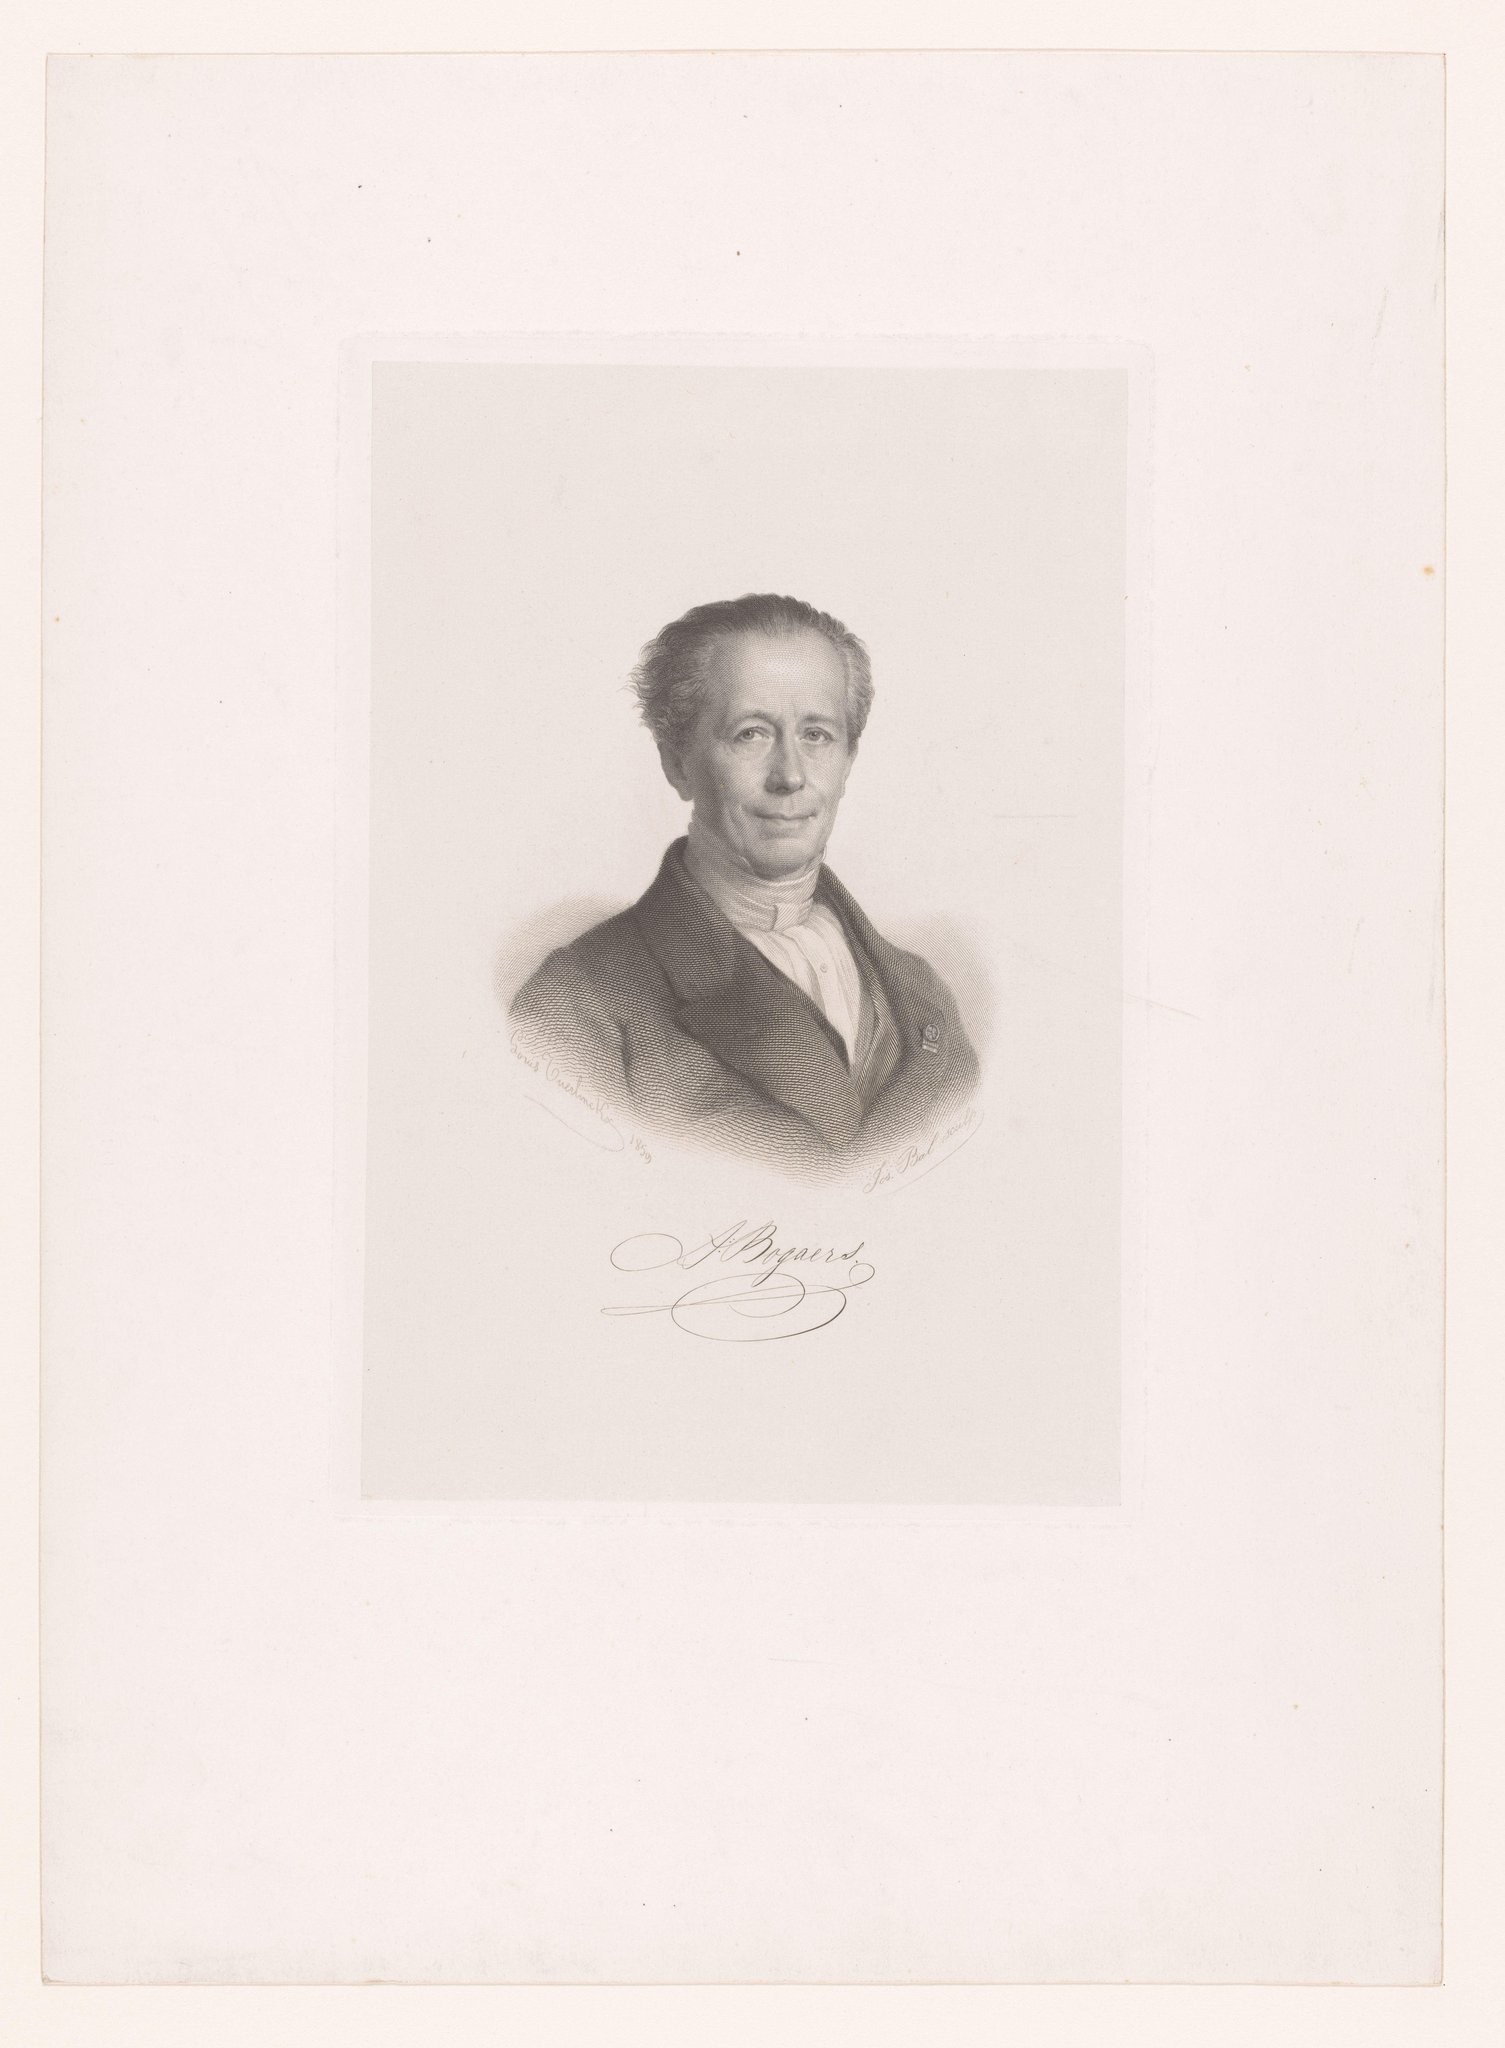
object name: print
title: A. Bogaers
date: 1830-1867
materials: paper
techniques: engraving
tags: the hague, adrianus bogaers, portrait of a writer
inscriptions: collector's mark: Lugt 2228